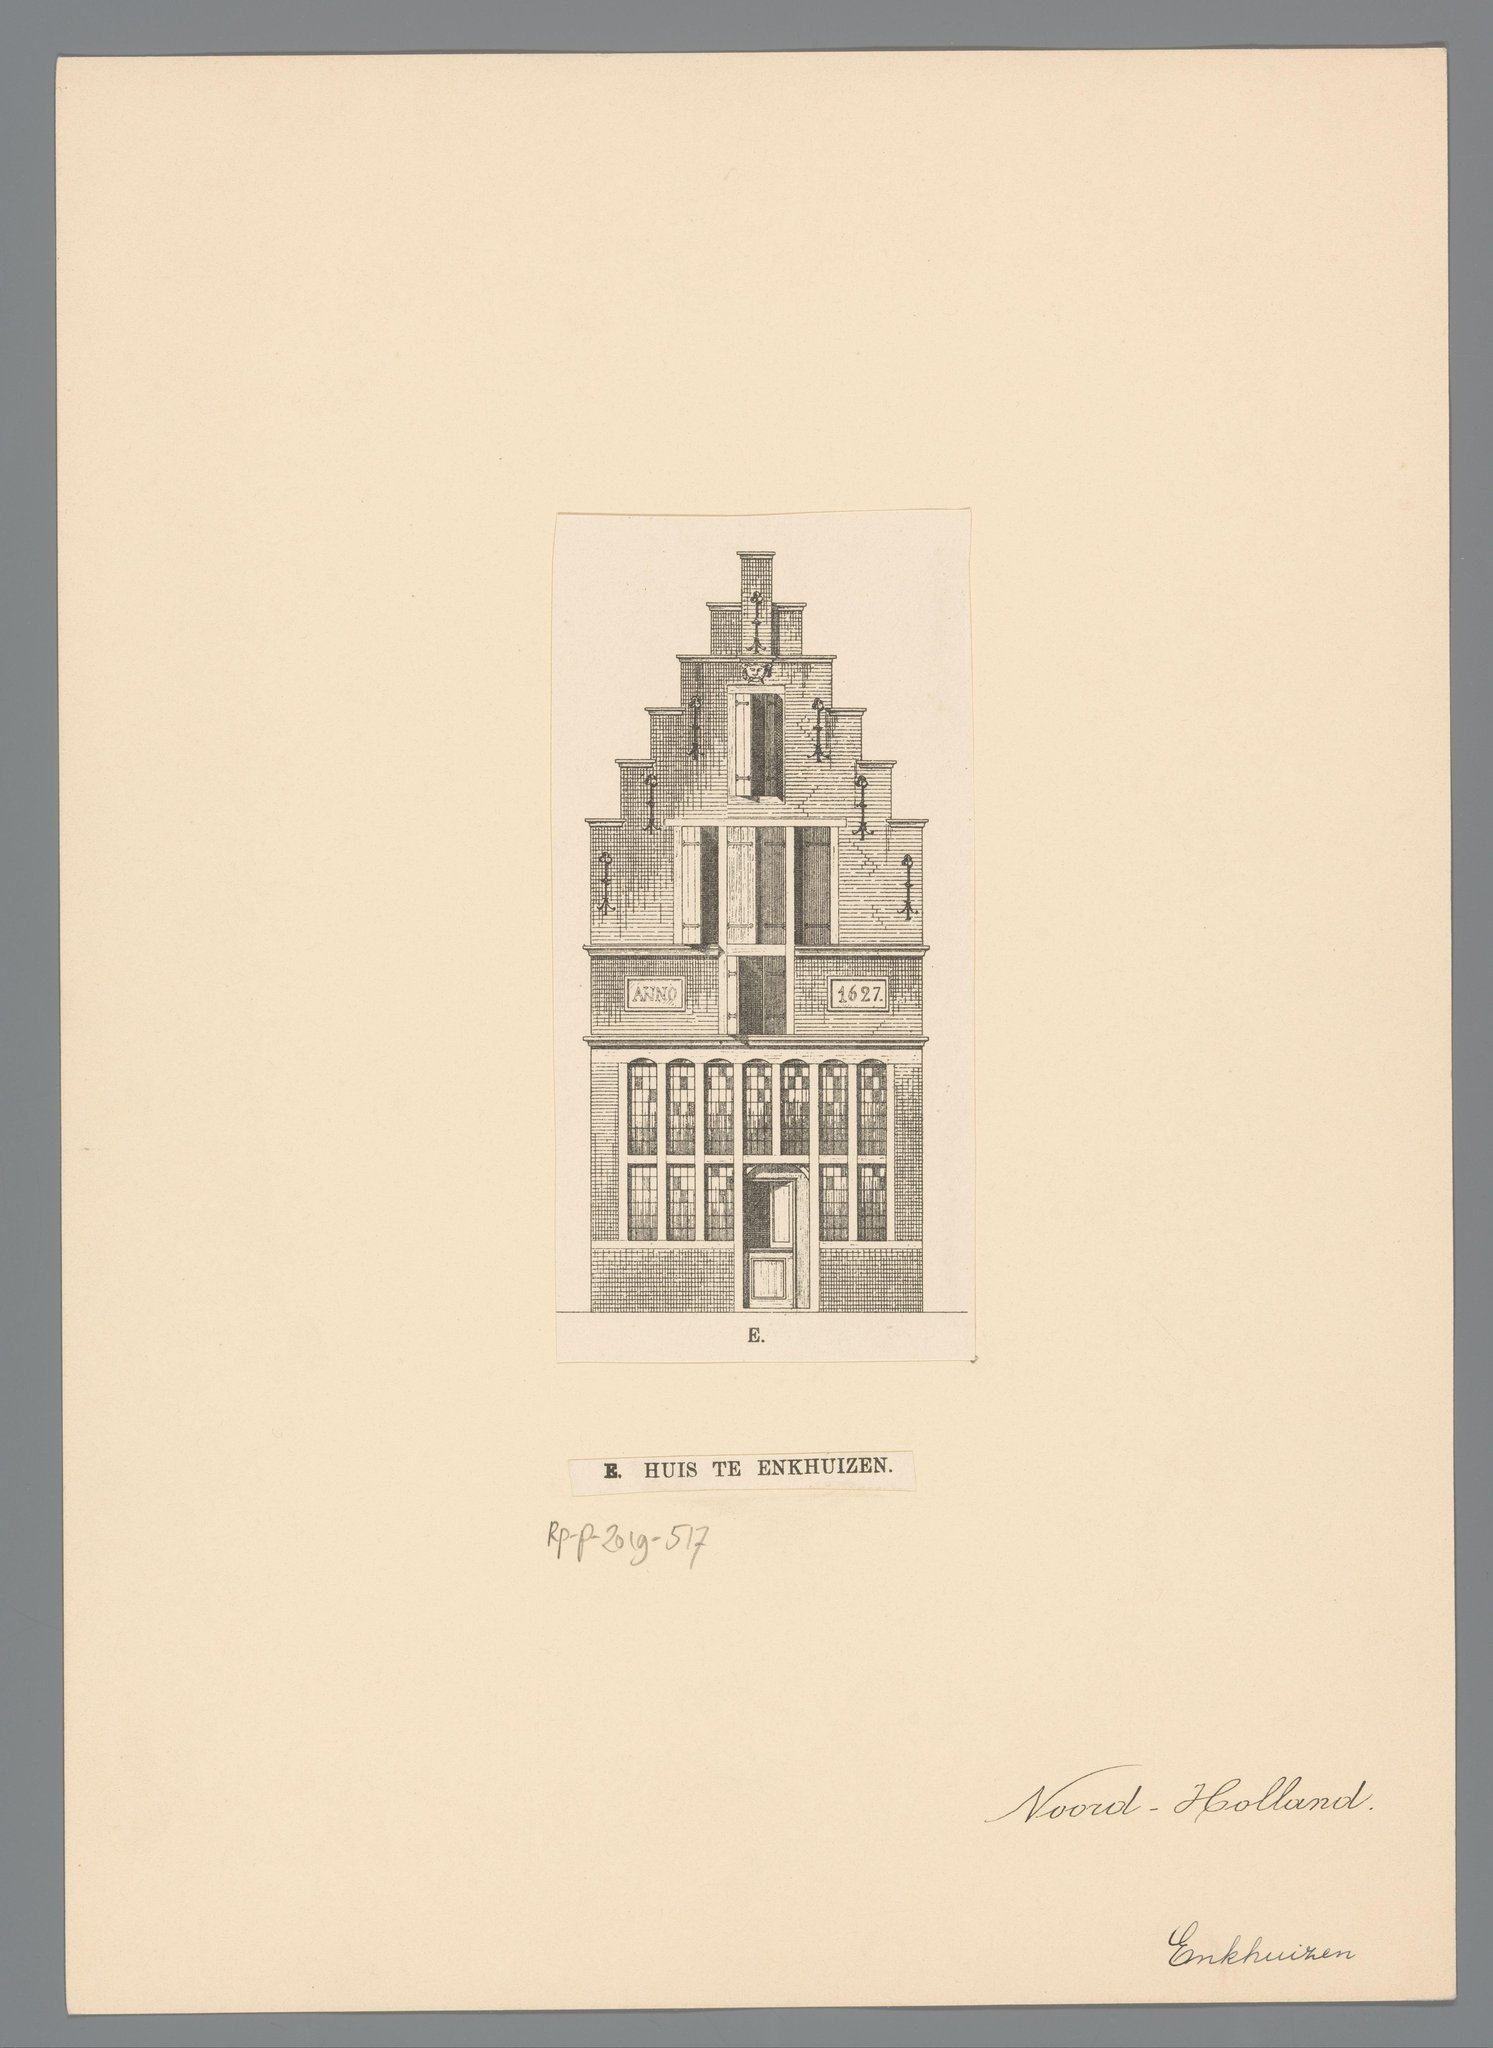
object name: print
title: Huis te Enkhuizen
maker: Anonymous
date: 1850-1900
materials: paper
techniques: lithograph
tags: façade (of house or building), enkhuizen